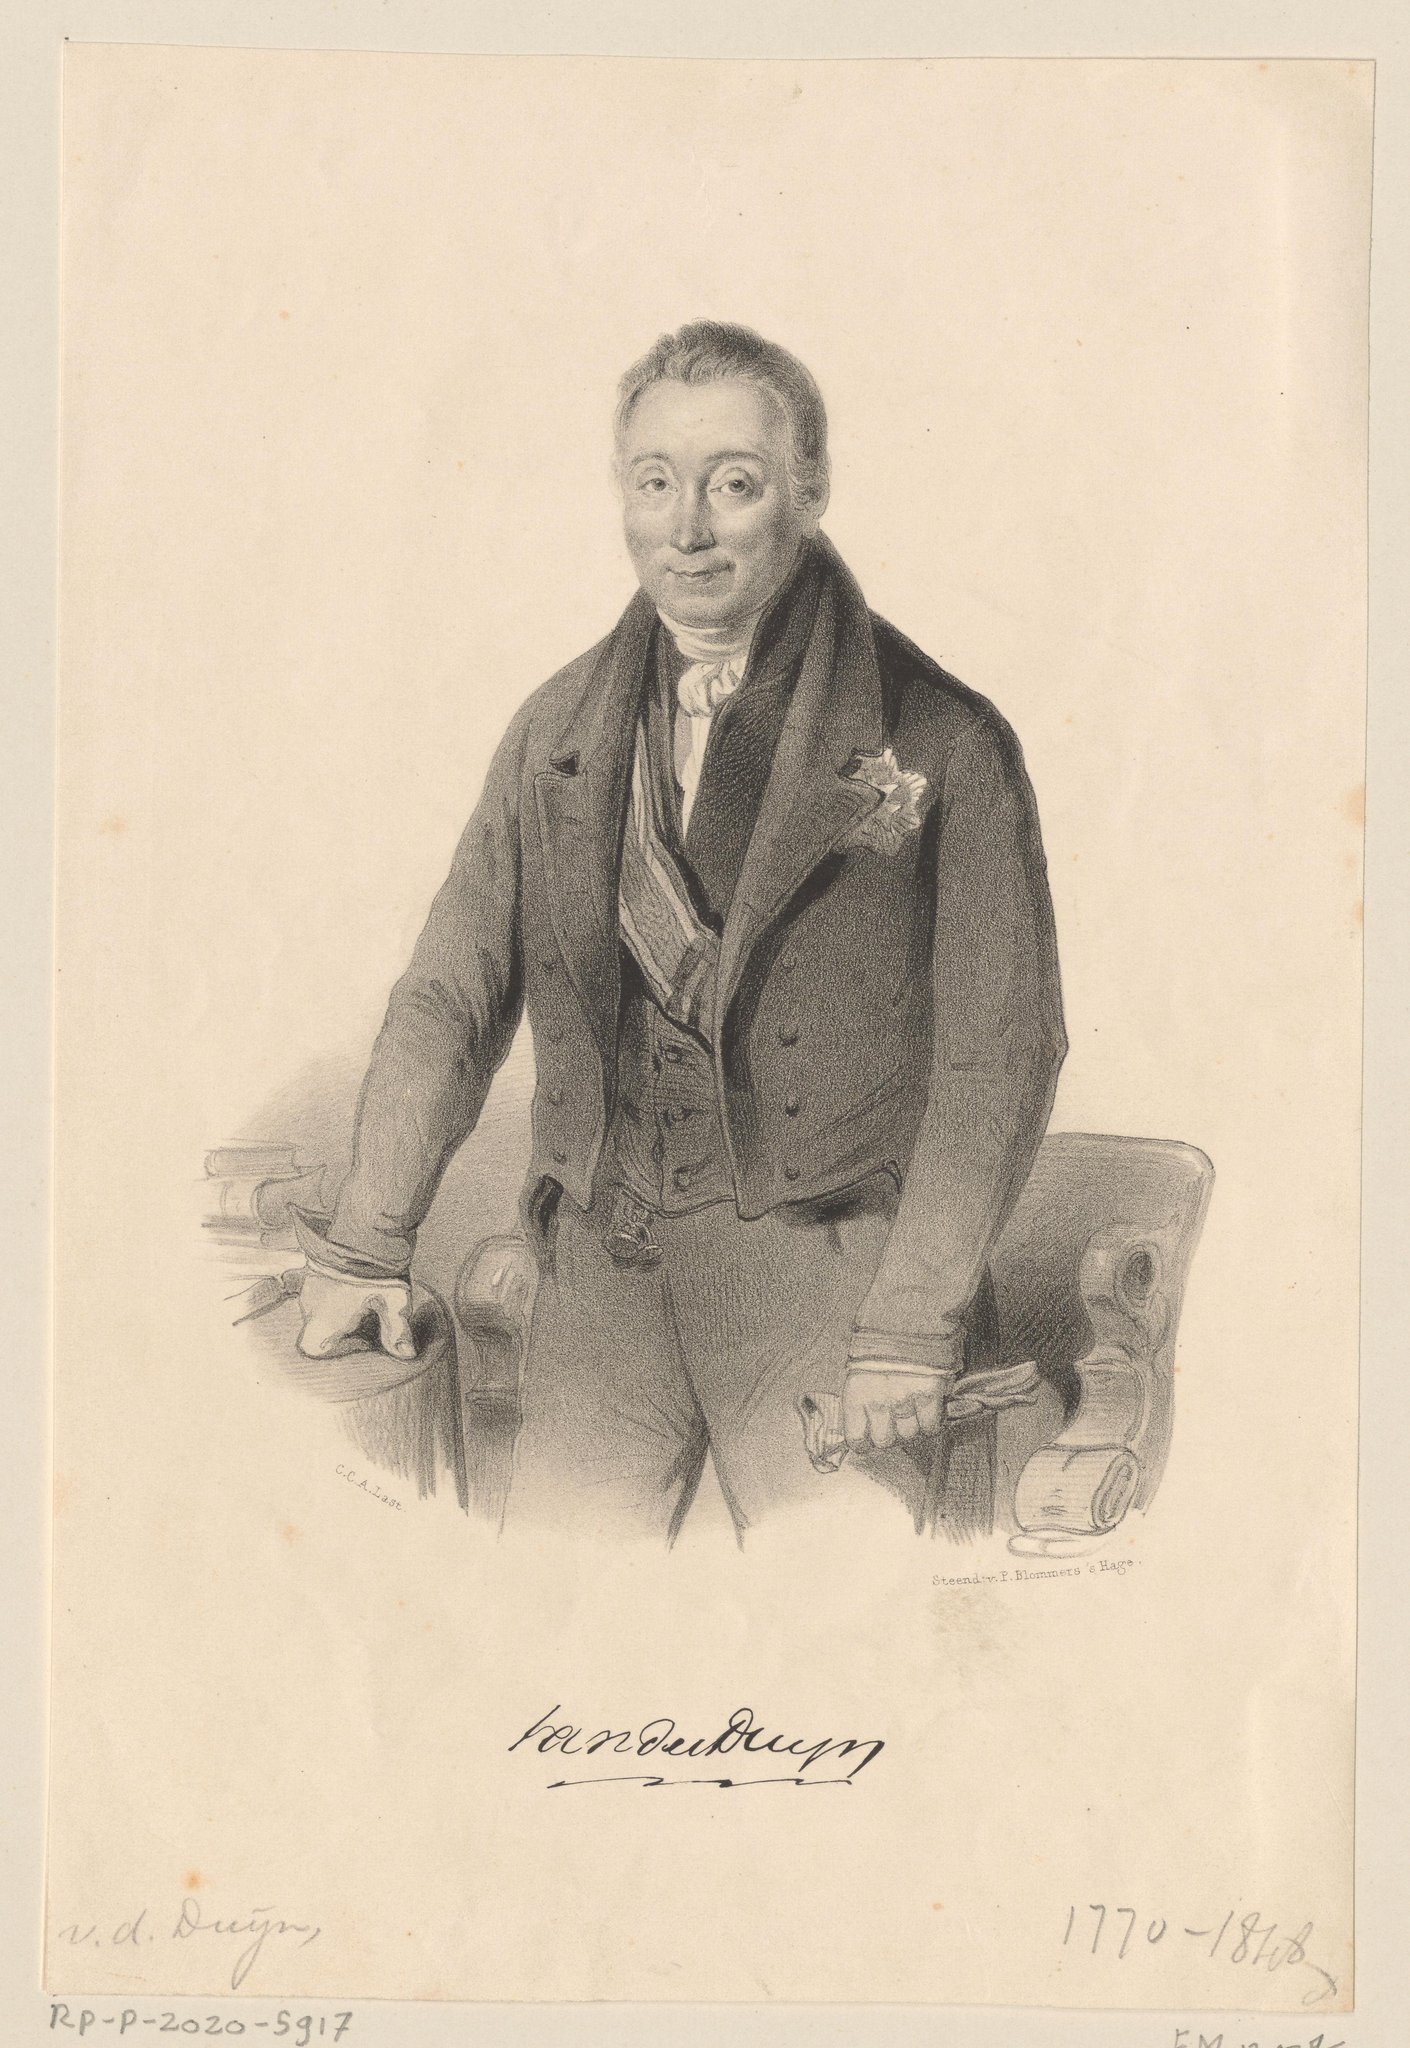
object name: print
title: Portret van Adam François Jules Armand van der Duyn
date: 1842-1853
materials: paper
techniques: lithograph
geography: the hague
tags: deventer, the hague, adam françois jules armand van der duyn, official; civil servant; functionary (in general), historical persons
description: Het schilderij waar deze prent naar gemaakt is, bevindt zich ook in de collectie van het Rijksmuseum, zie SK-A-1495.